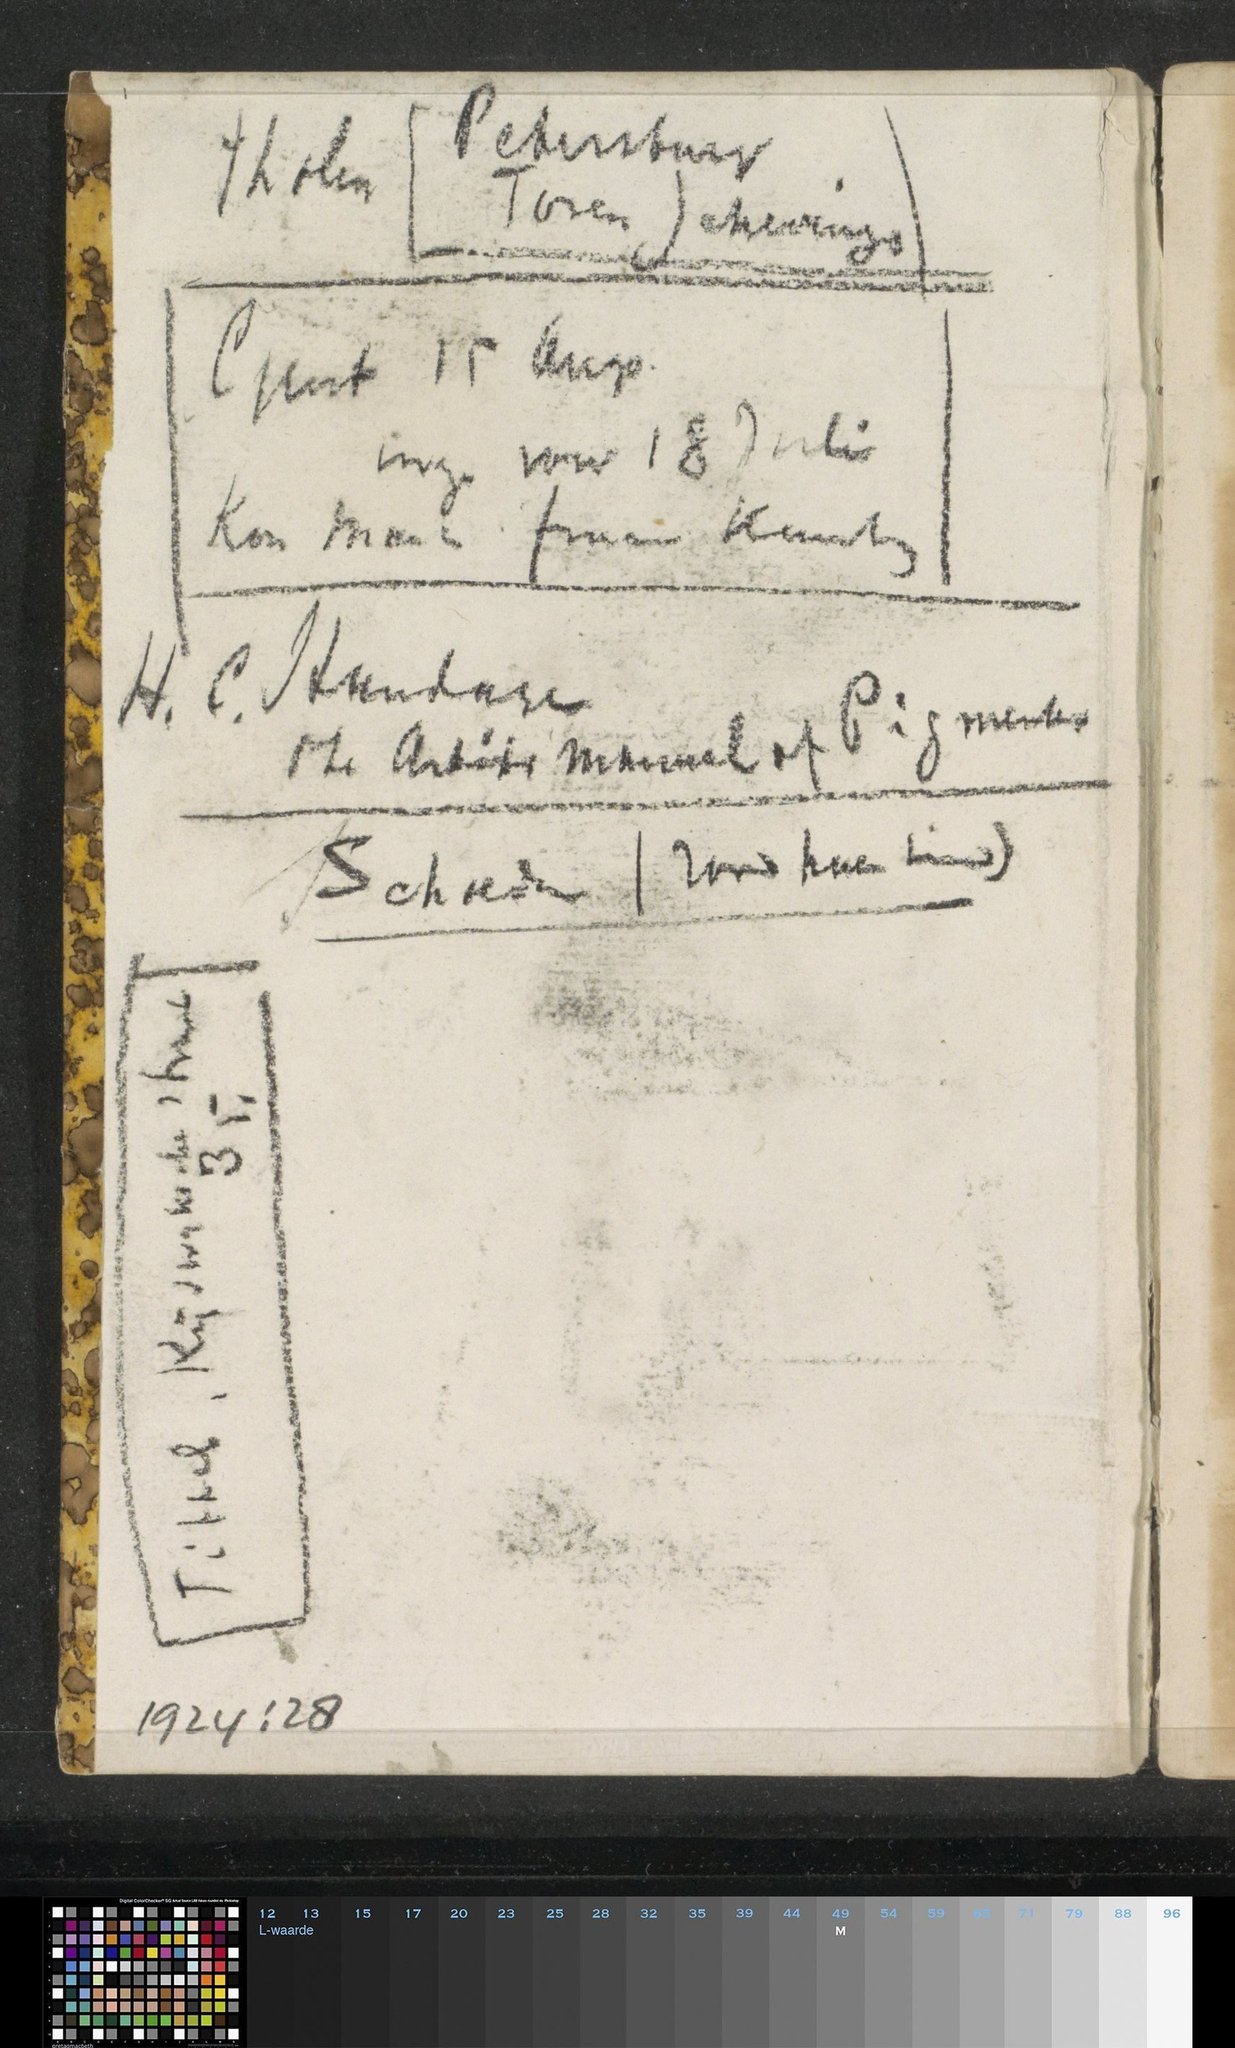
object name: endleaf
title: Annotaties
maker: george hendrik breitner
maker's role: draughtsman, painter, print maker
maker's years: 1857-1923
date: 1883-1885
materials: chalk, paper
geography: the hague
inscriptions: annotation: ‘Tholen/ Petersburg/ Toren Scherrings/ Gent 15 Aug./ inz. voor 18 Juli/ Kon Museum Schone Kunsten/ H.C. Standage/ The Artists' Manual of Pigments/ [...]’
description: Pagina 1, voorste schutblad, uit een schetsboek met 18 bladen.